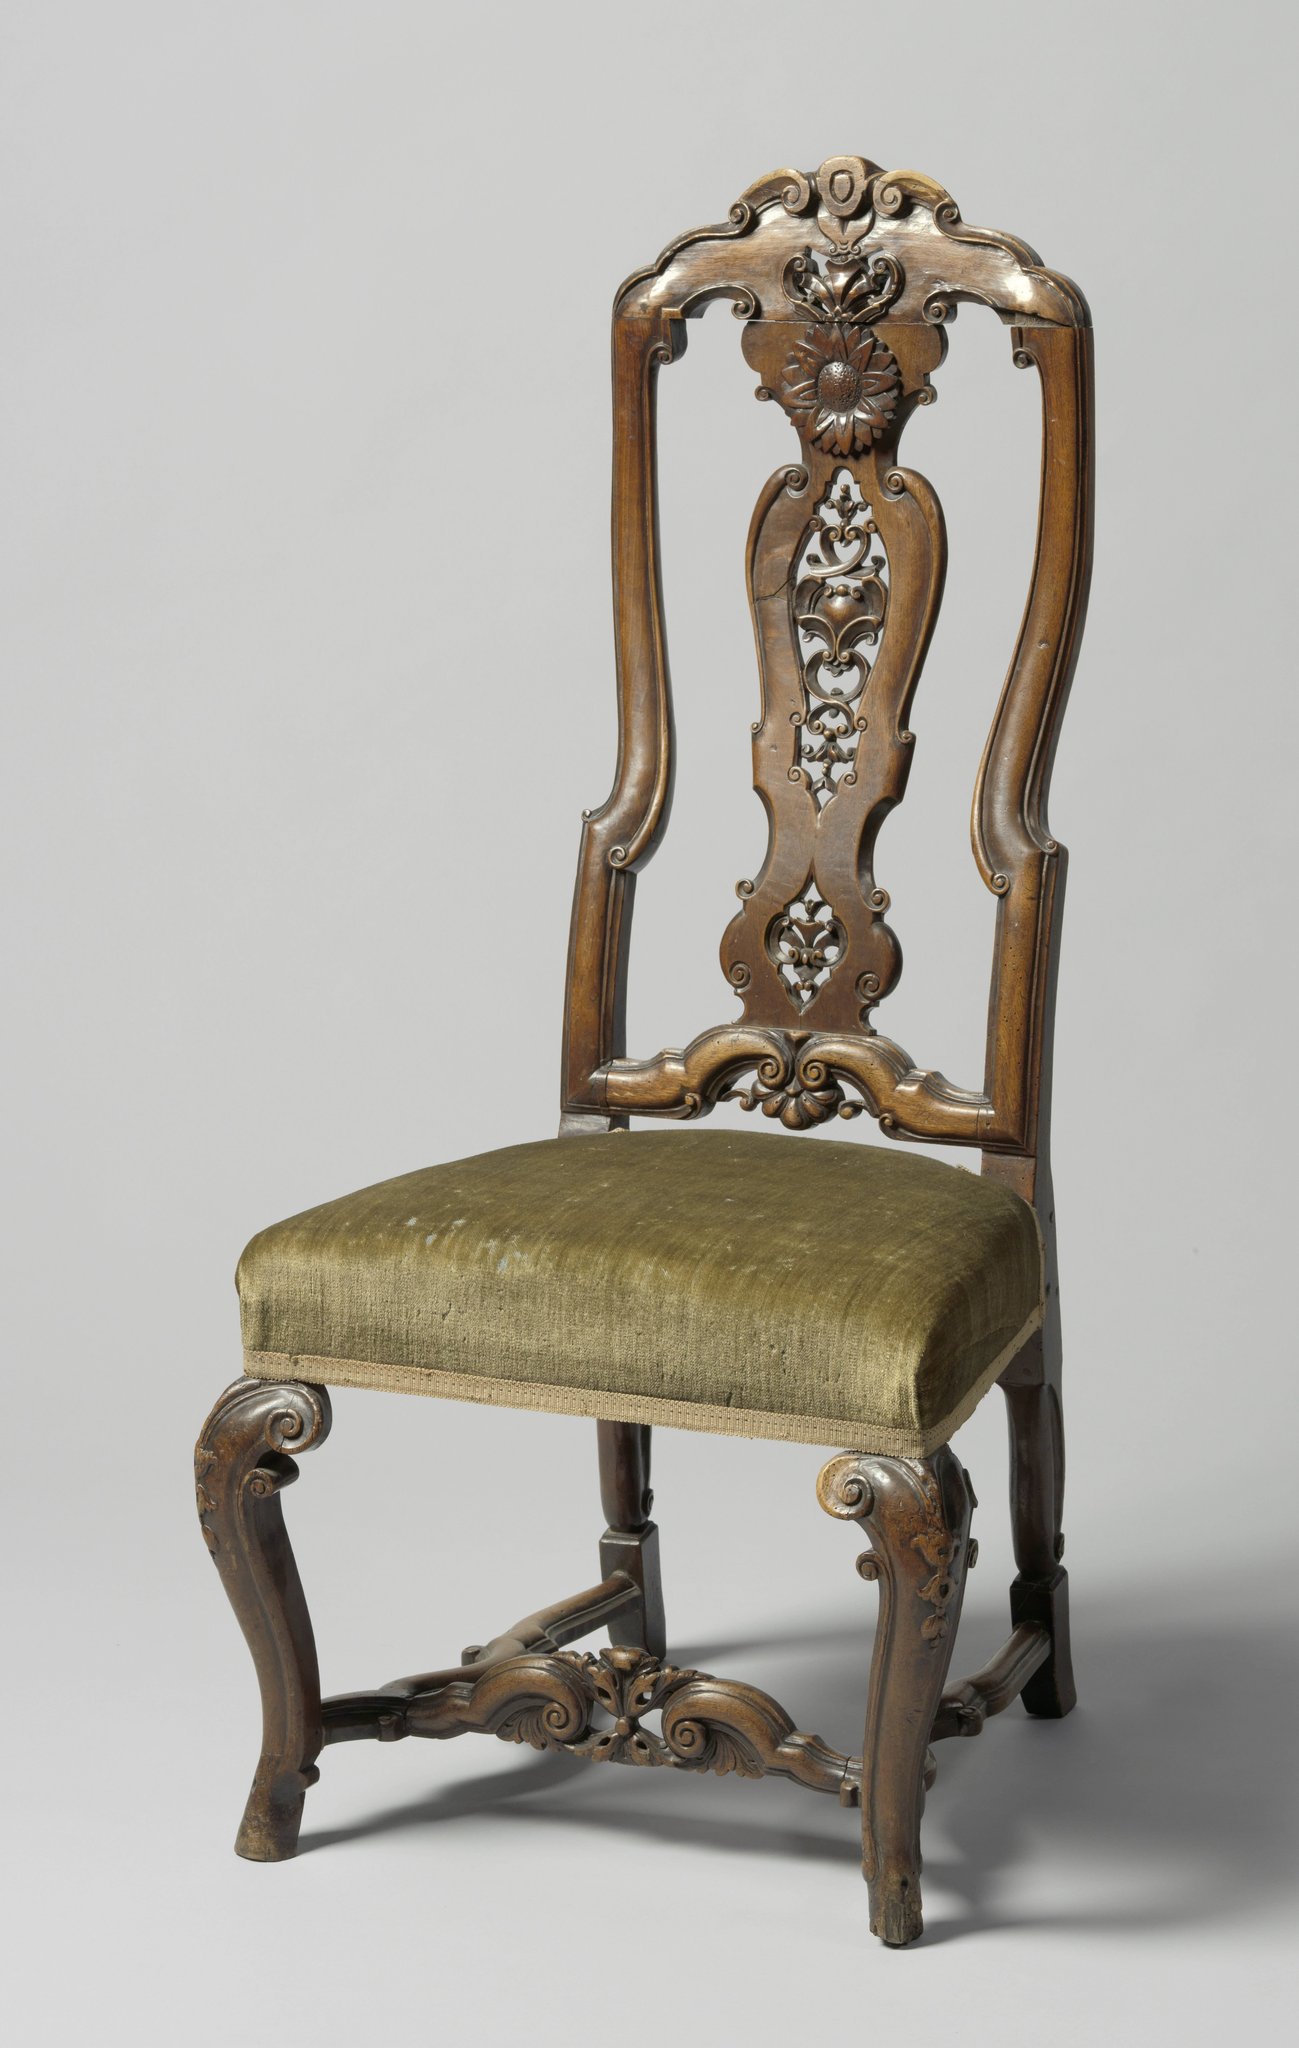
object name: seating furniture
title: Stoel van notenhout met hoge rug met snijwerk van C-voluten en zonnebloem. Overhoeks geplaatste S-vormige voorpoten; kruis met geschulpte zijsporten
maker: Anonymous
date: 1700-1725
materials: wood, textile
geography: netherlands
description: Beklede stoel van notenhout. De achterpoten wijken achterwaarts en de overhoeks geplaatste S-vormige voorpoten op bokshoeven hebben bovenaan een in voluten eindigende verbreding en versierde zwellingen. Het kruis heeft geschulpte zijsporten; voorsport met acanthusblad tussen toegewende C-voluten. De hoge rug, heeft een middenblad met C-voluten en zonnebloem en een geschulpte bovendorpel met schelpmotief, beiden opengewerkt. De onderdorpel vertoont voluten met schelp. Bovendeel der stijlen is gerekt S-vormig.